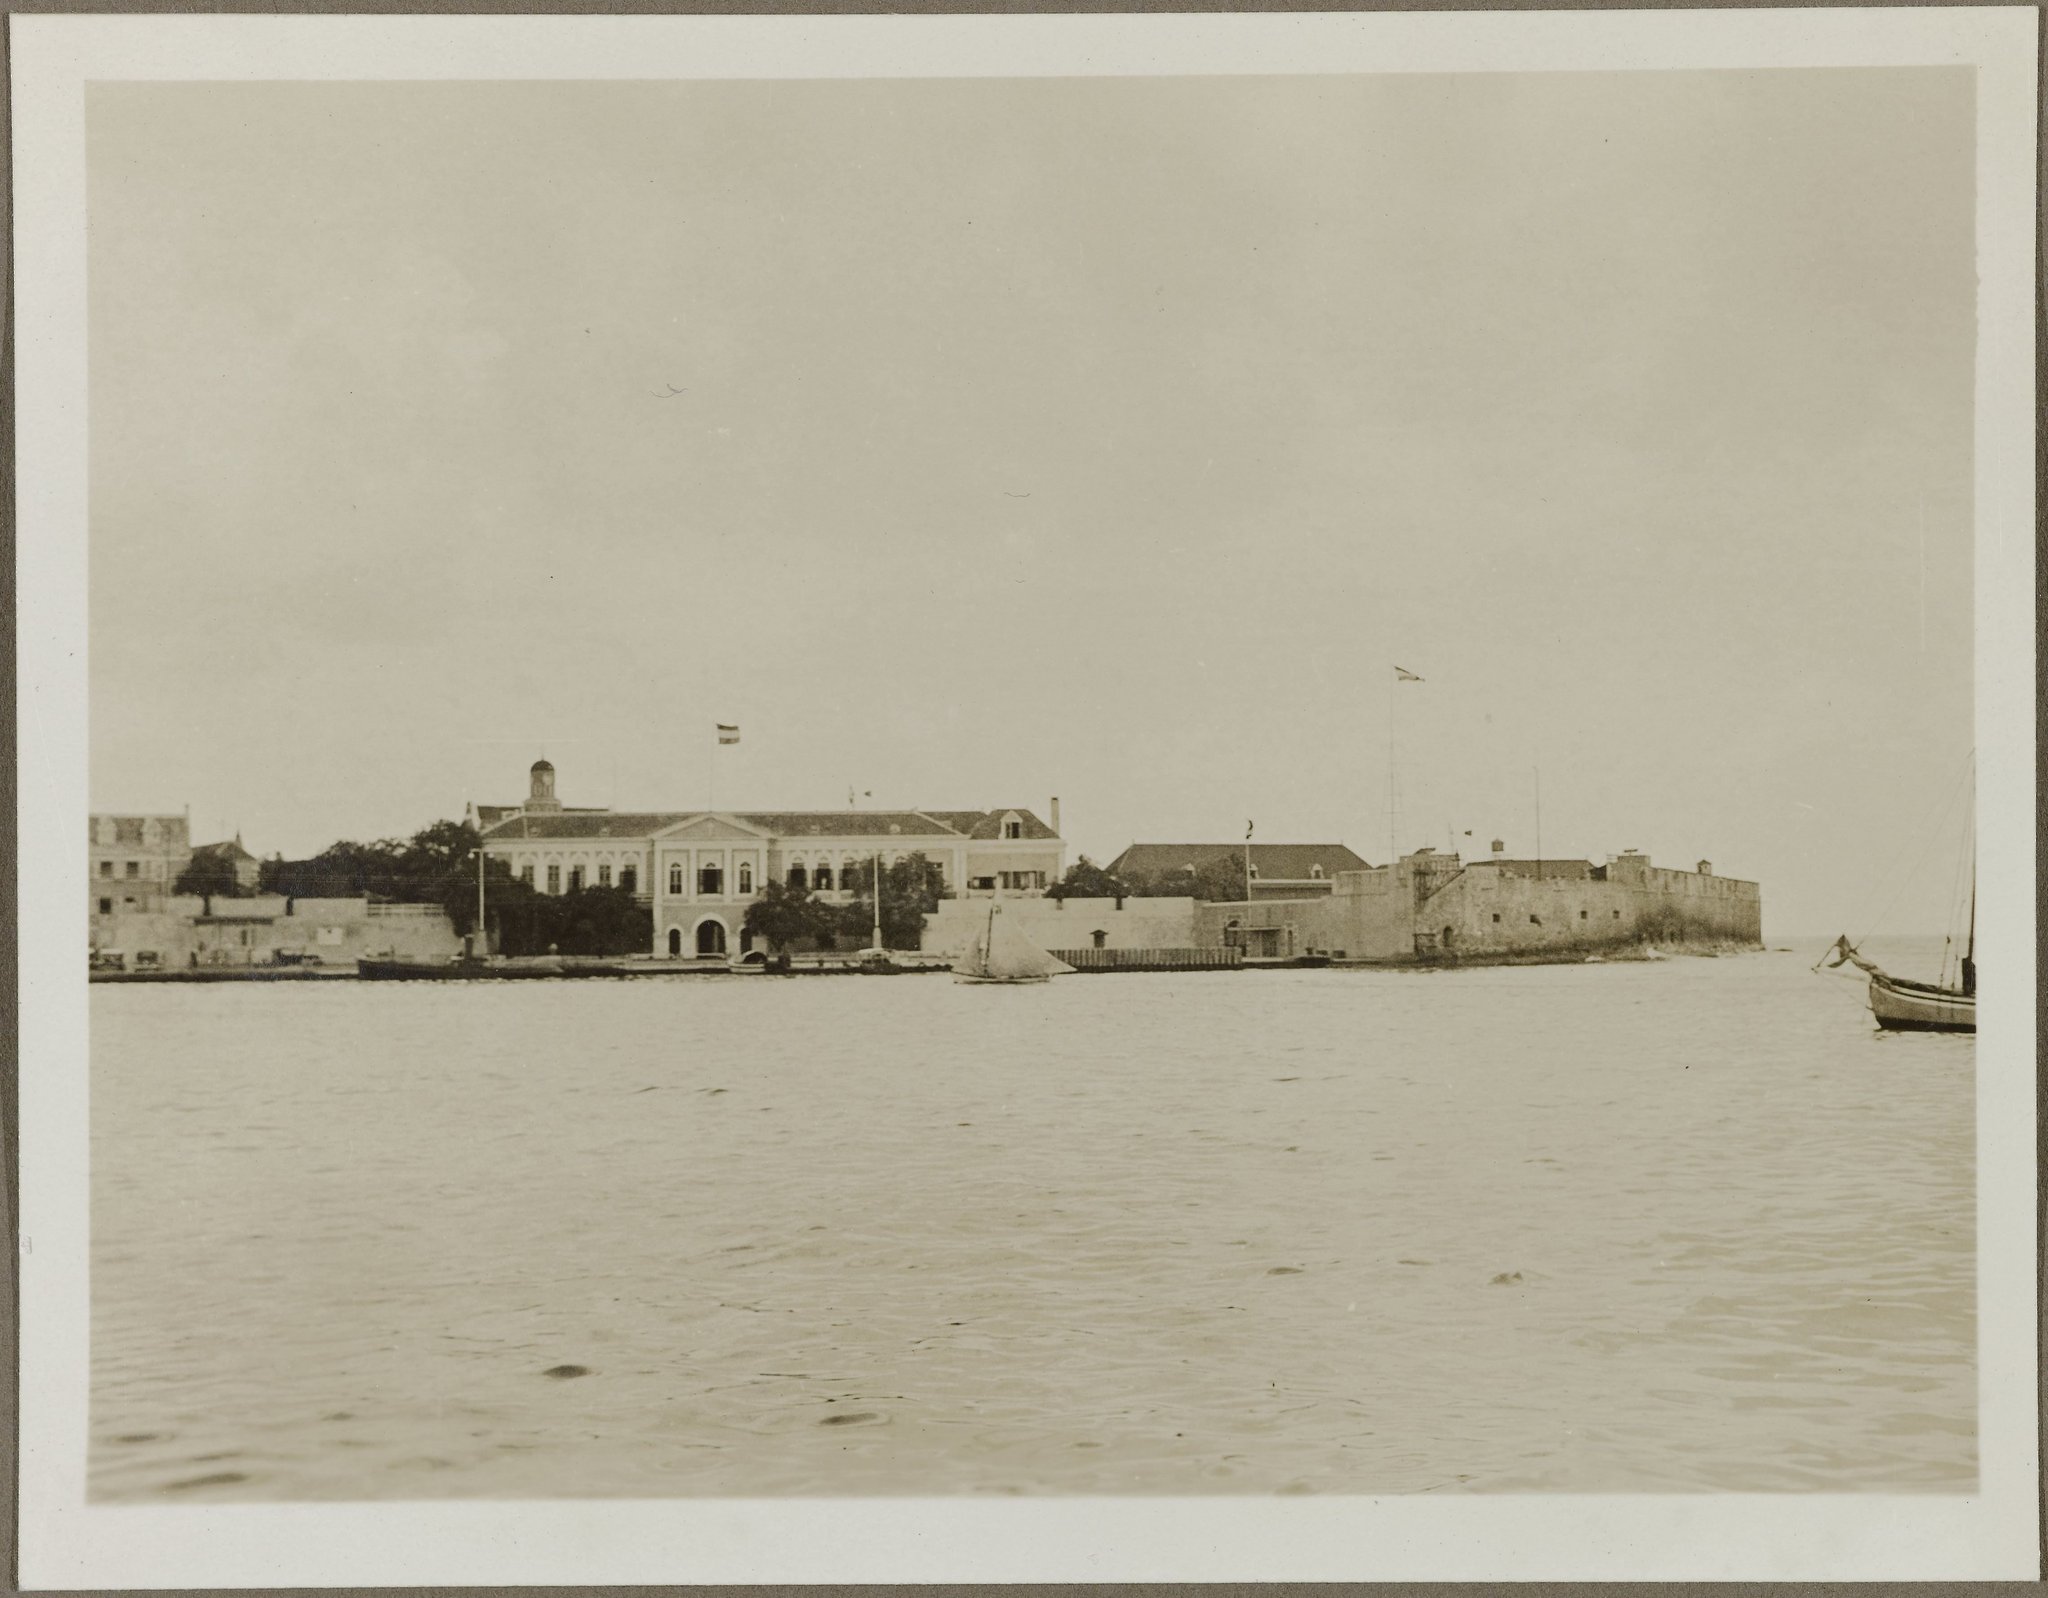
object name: photograph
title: Gouvernementshuis en fort in Willemstad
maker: Anonymous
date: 1925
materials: photographic support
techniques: photography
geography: curacao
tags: fortress